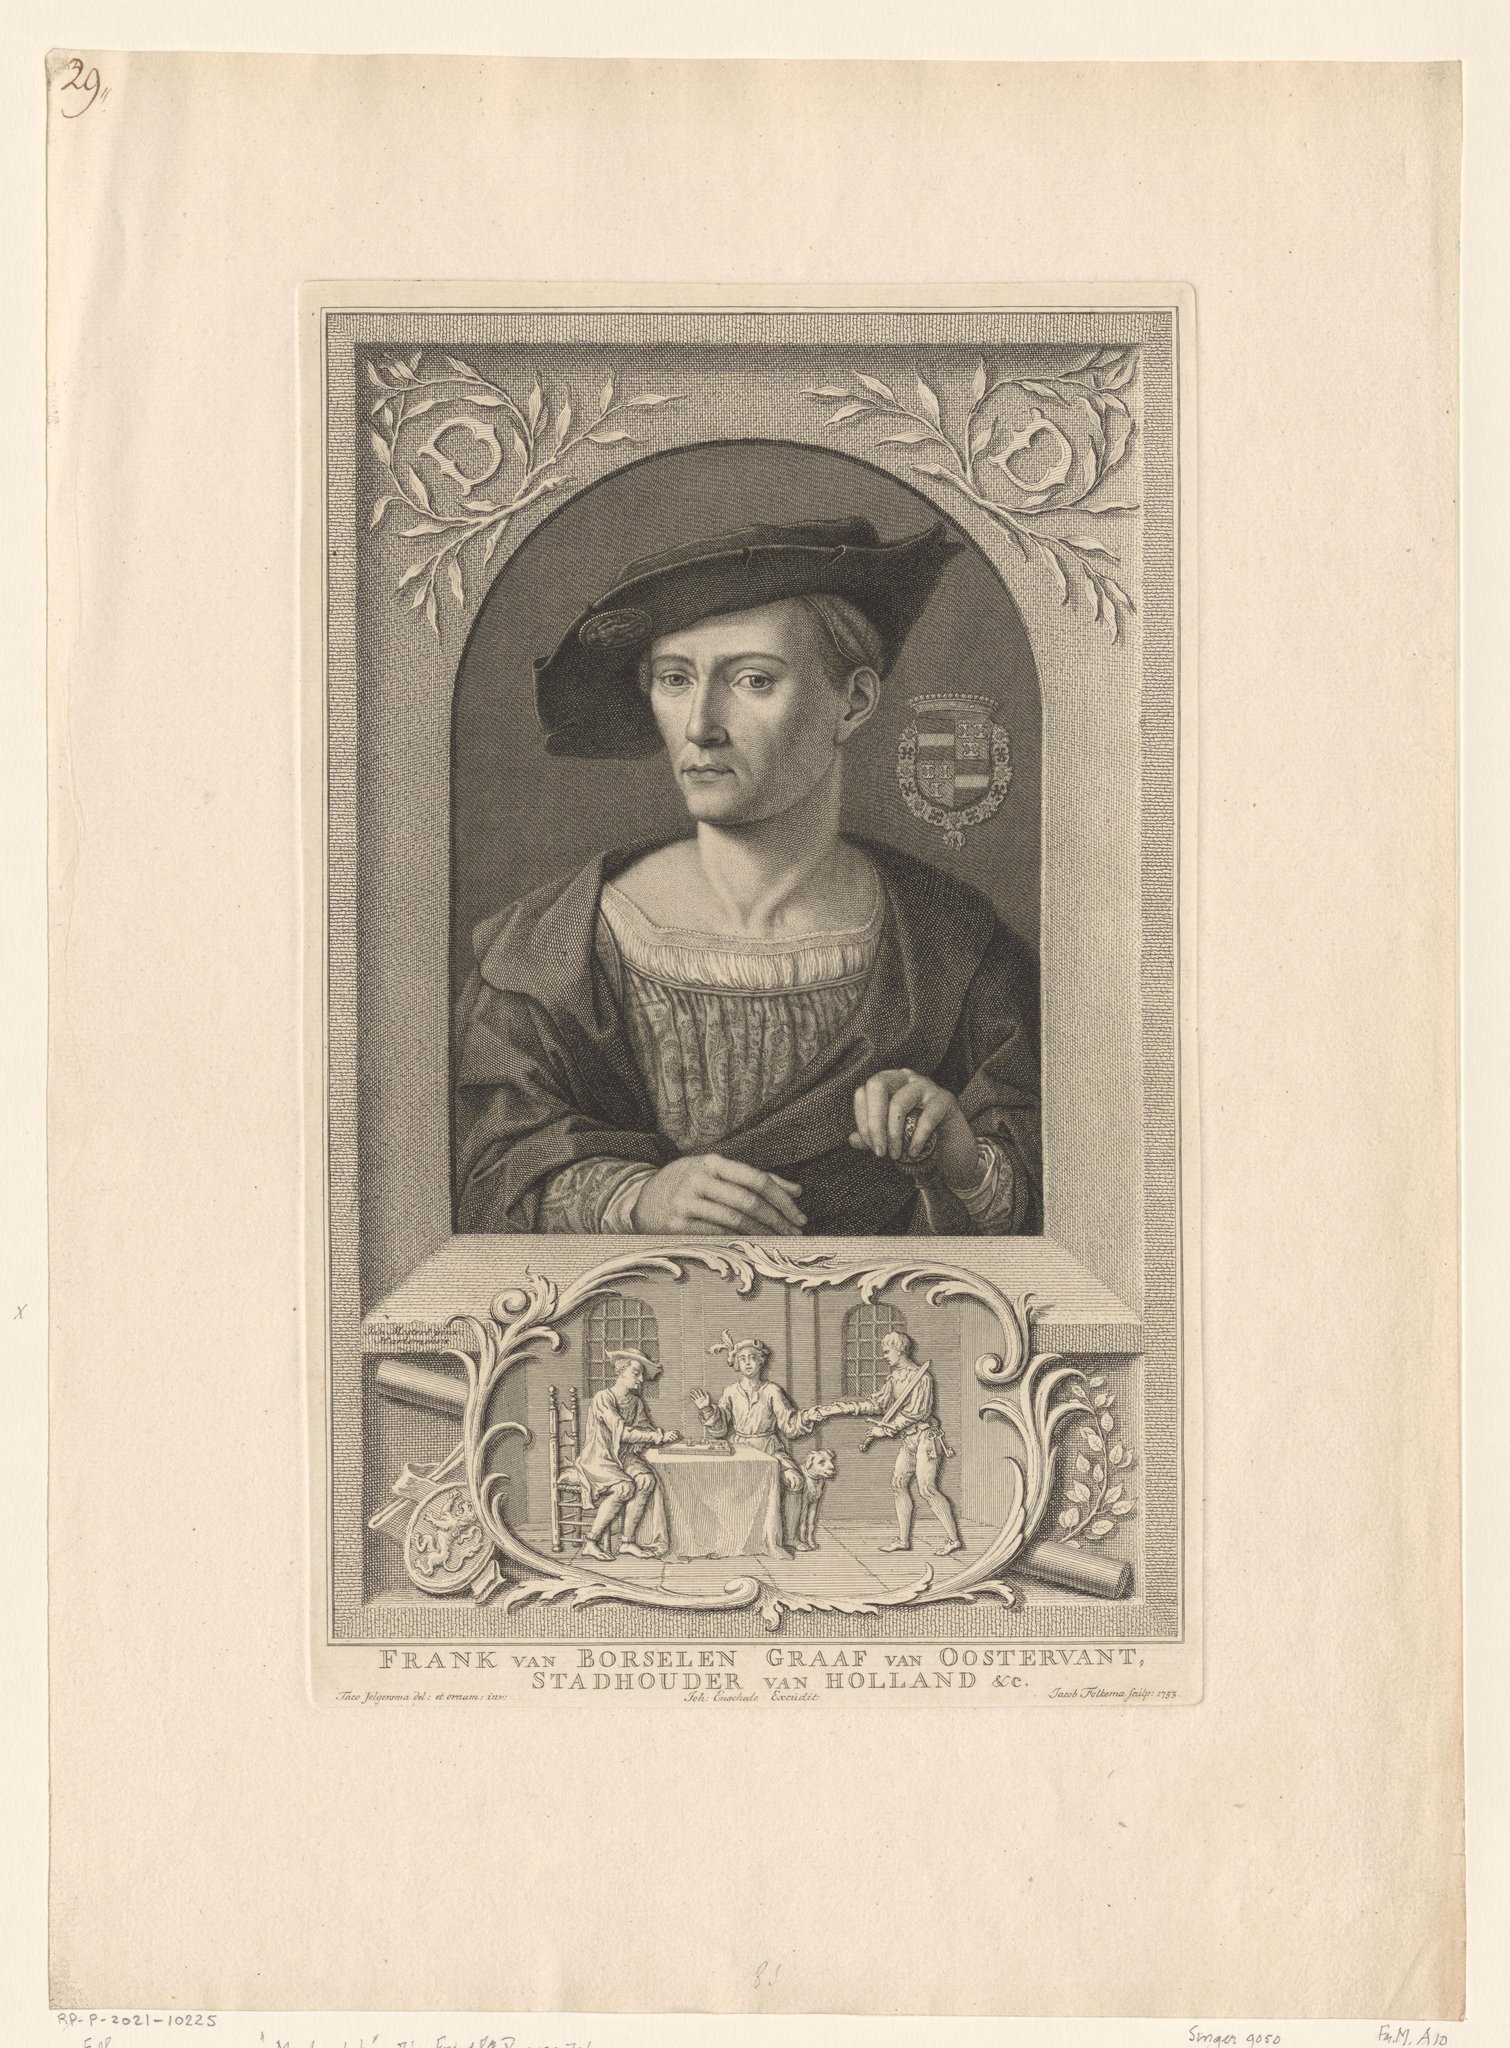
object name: print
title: Portret van Frank van Borselen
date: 1753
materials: paper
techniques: etching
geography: haarlem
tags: historical persons, board-games (+ sportsman, player, etc.), armorial bearing, heraldry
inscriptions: inscription: ‘29,,’, collector's mark: Lugt 2228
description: Met midden onder een vignet met daarop twee mannen die een bordspel spelen en een derde die een brief overhandigt.